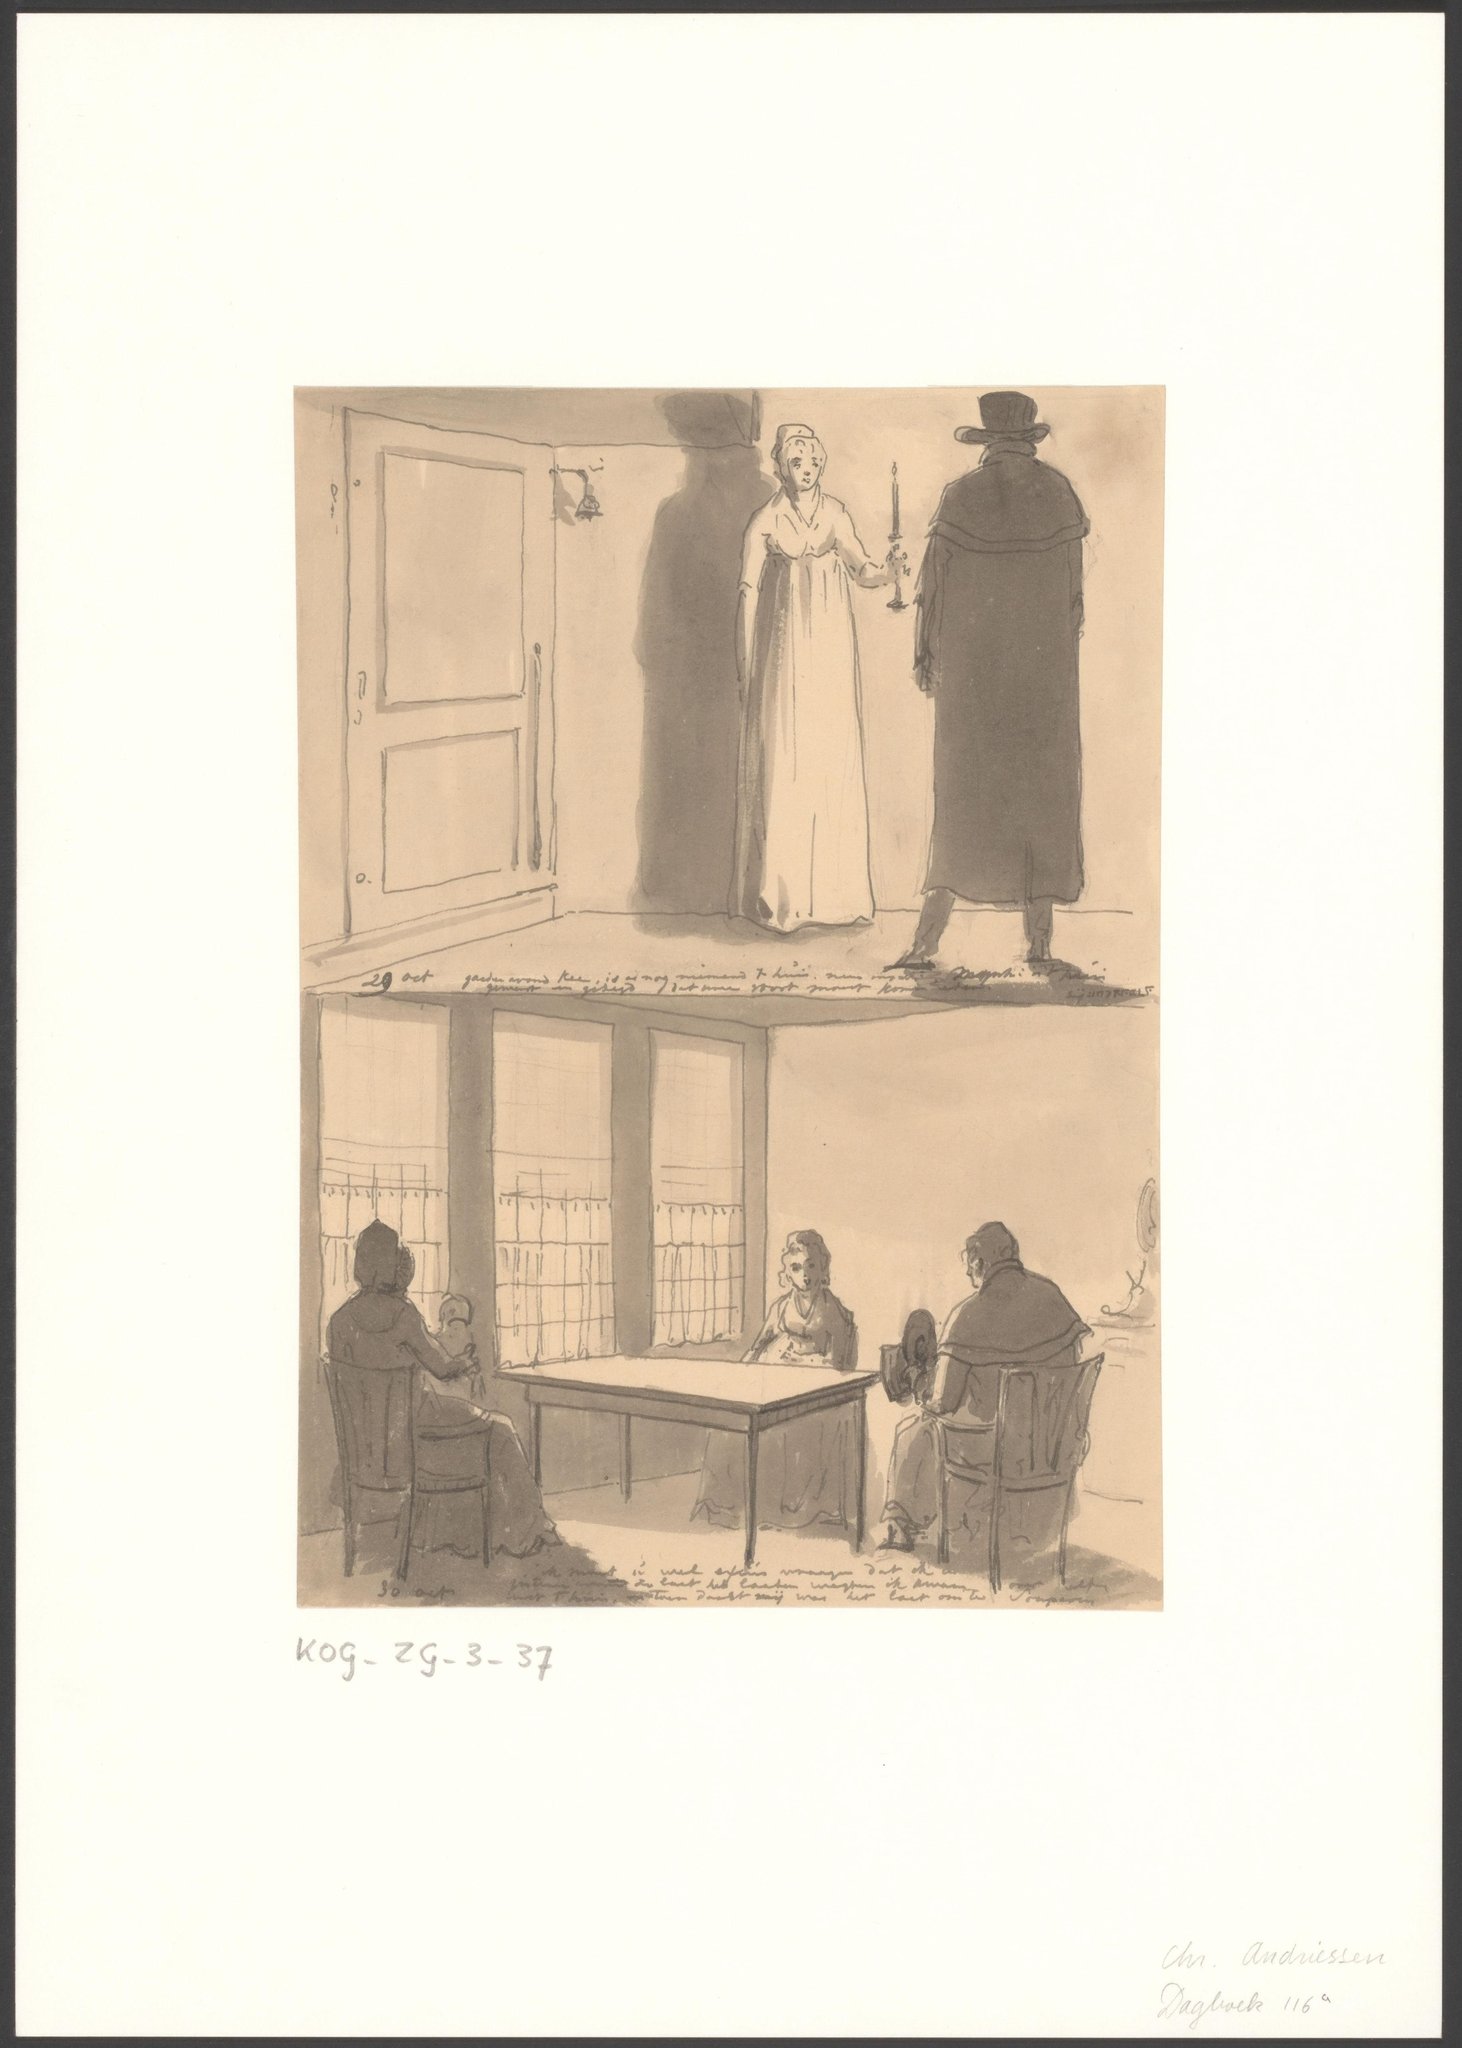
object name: drawing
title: Christiaan Andriessen laat aan in een huis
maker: christiaan andriessen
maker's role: draughtsman, print maker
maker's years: 1775-1846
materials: ink, paper, pencil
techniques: pen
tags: nightwear: night-cap, lateness, table, nightwear: night-gown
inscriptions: collector's mark: Lugt 1641, inscription: ‘29 oct goede avond Kee, is er nog niemand t huis (...) 30 oct (...) Souperen’, collector's mark: Lugt 1641a, inscription: ‘J Andriessen’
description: Blad verdeeld in twee voorstellingen. Bovenaan komt Christiaan Andriessen laat aan in een huis. Kee laat hem binnen en heeft een kaars in haar hand. Onderaan